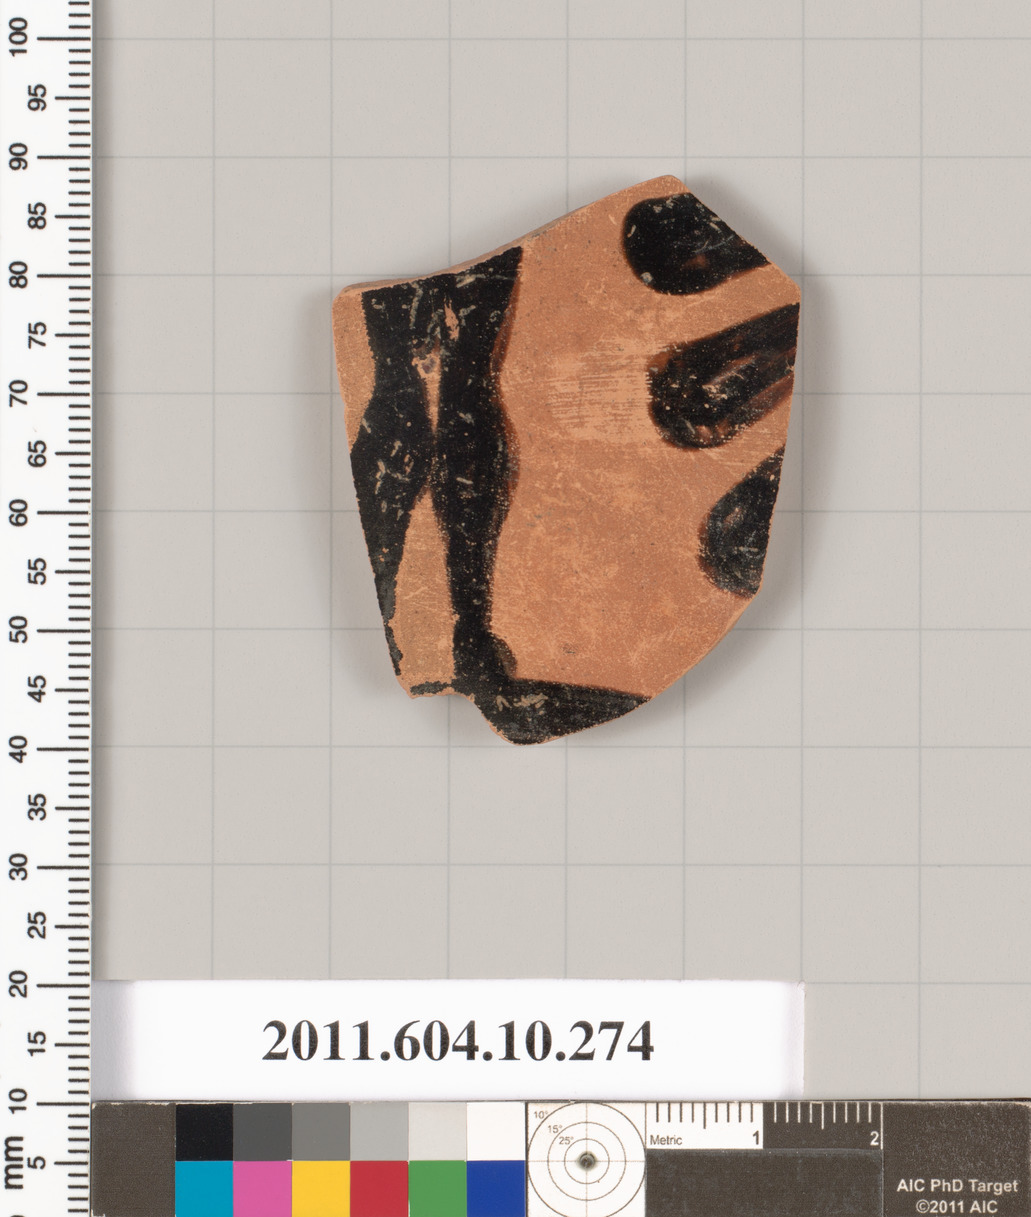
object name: unidentified closed shape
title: Terracotta fragment from a closed shape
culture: etruscan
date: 500-480 BCE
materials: terracotta